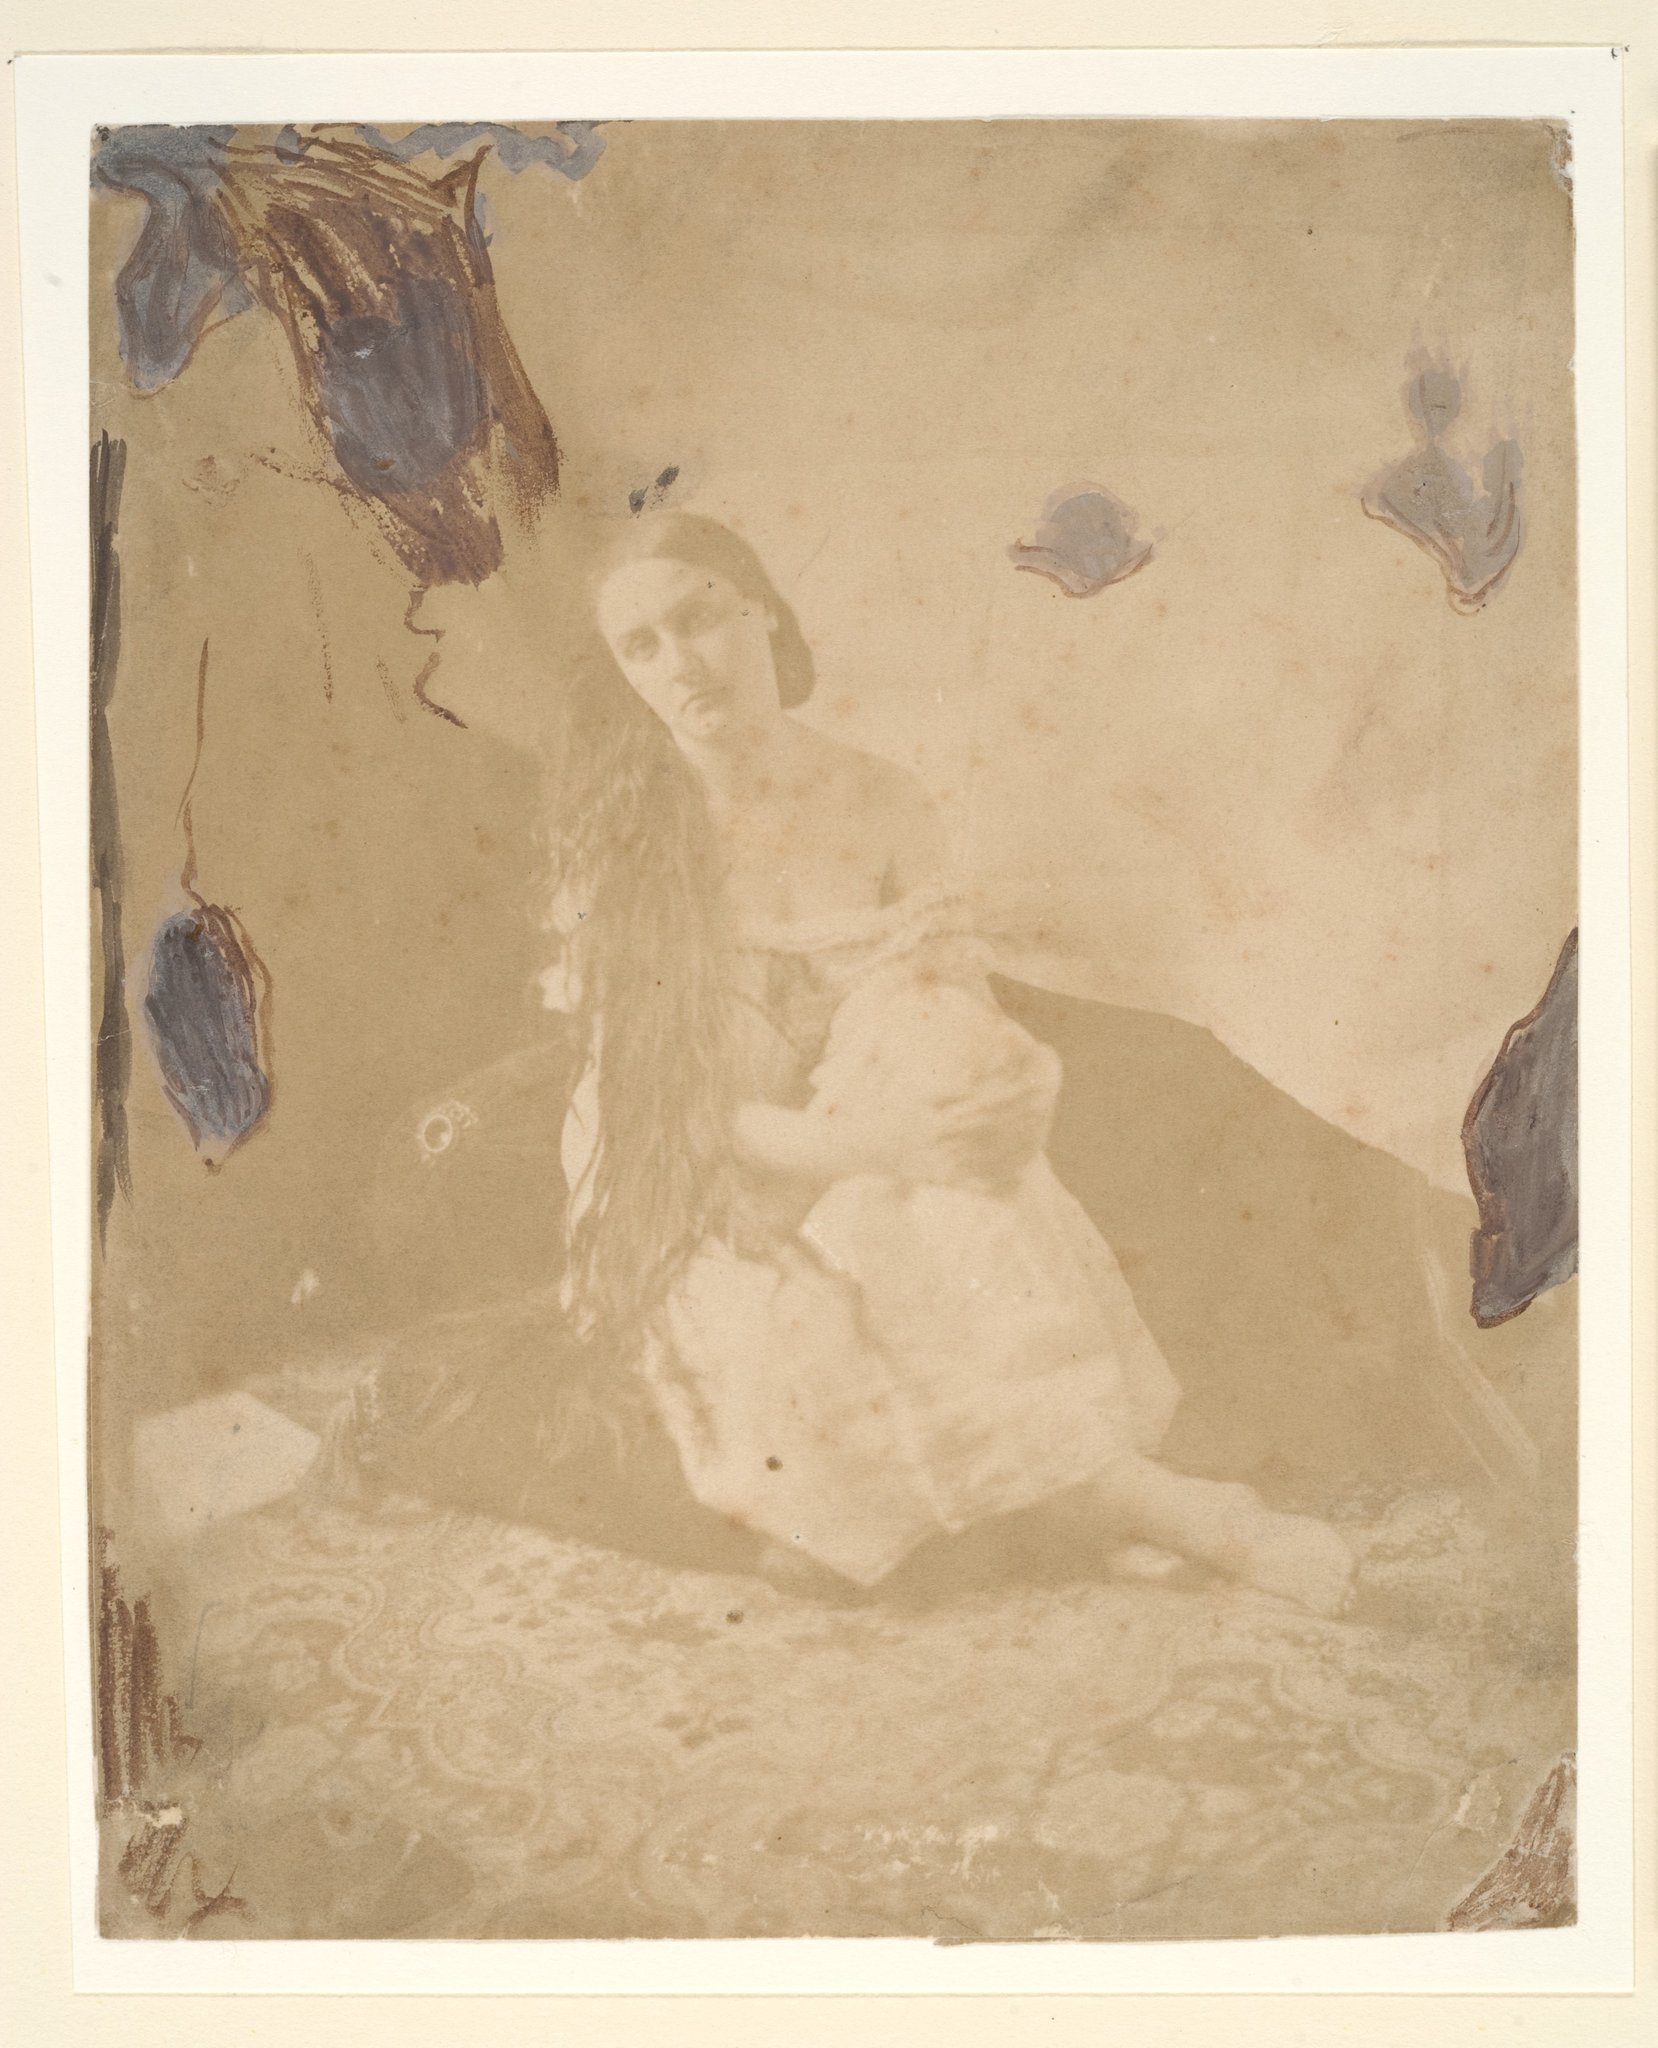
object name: photograph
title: La Chemise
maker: pierre-louis pierson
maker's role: artist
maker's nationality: french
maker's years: 1822-1913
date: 1860-1869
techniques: glass negative, salted paper print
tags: portraits,women